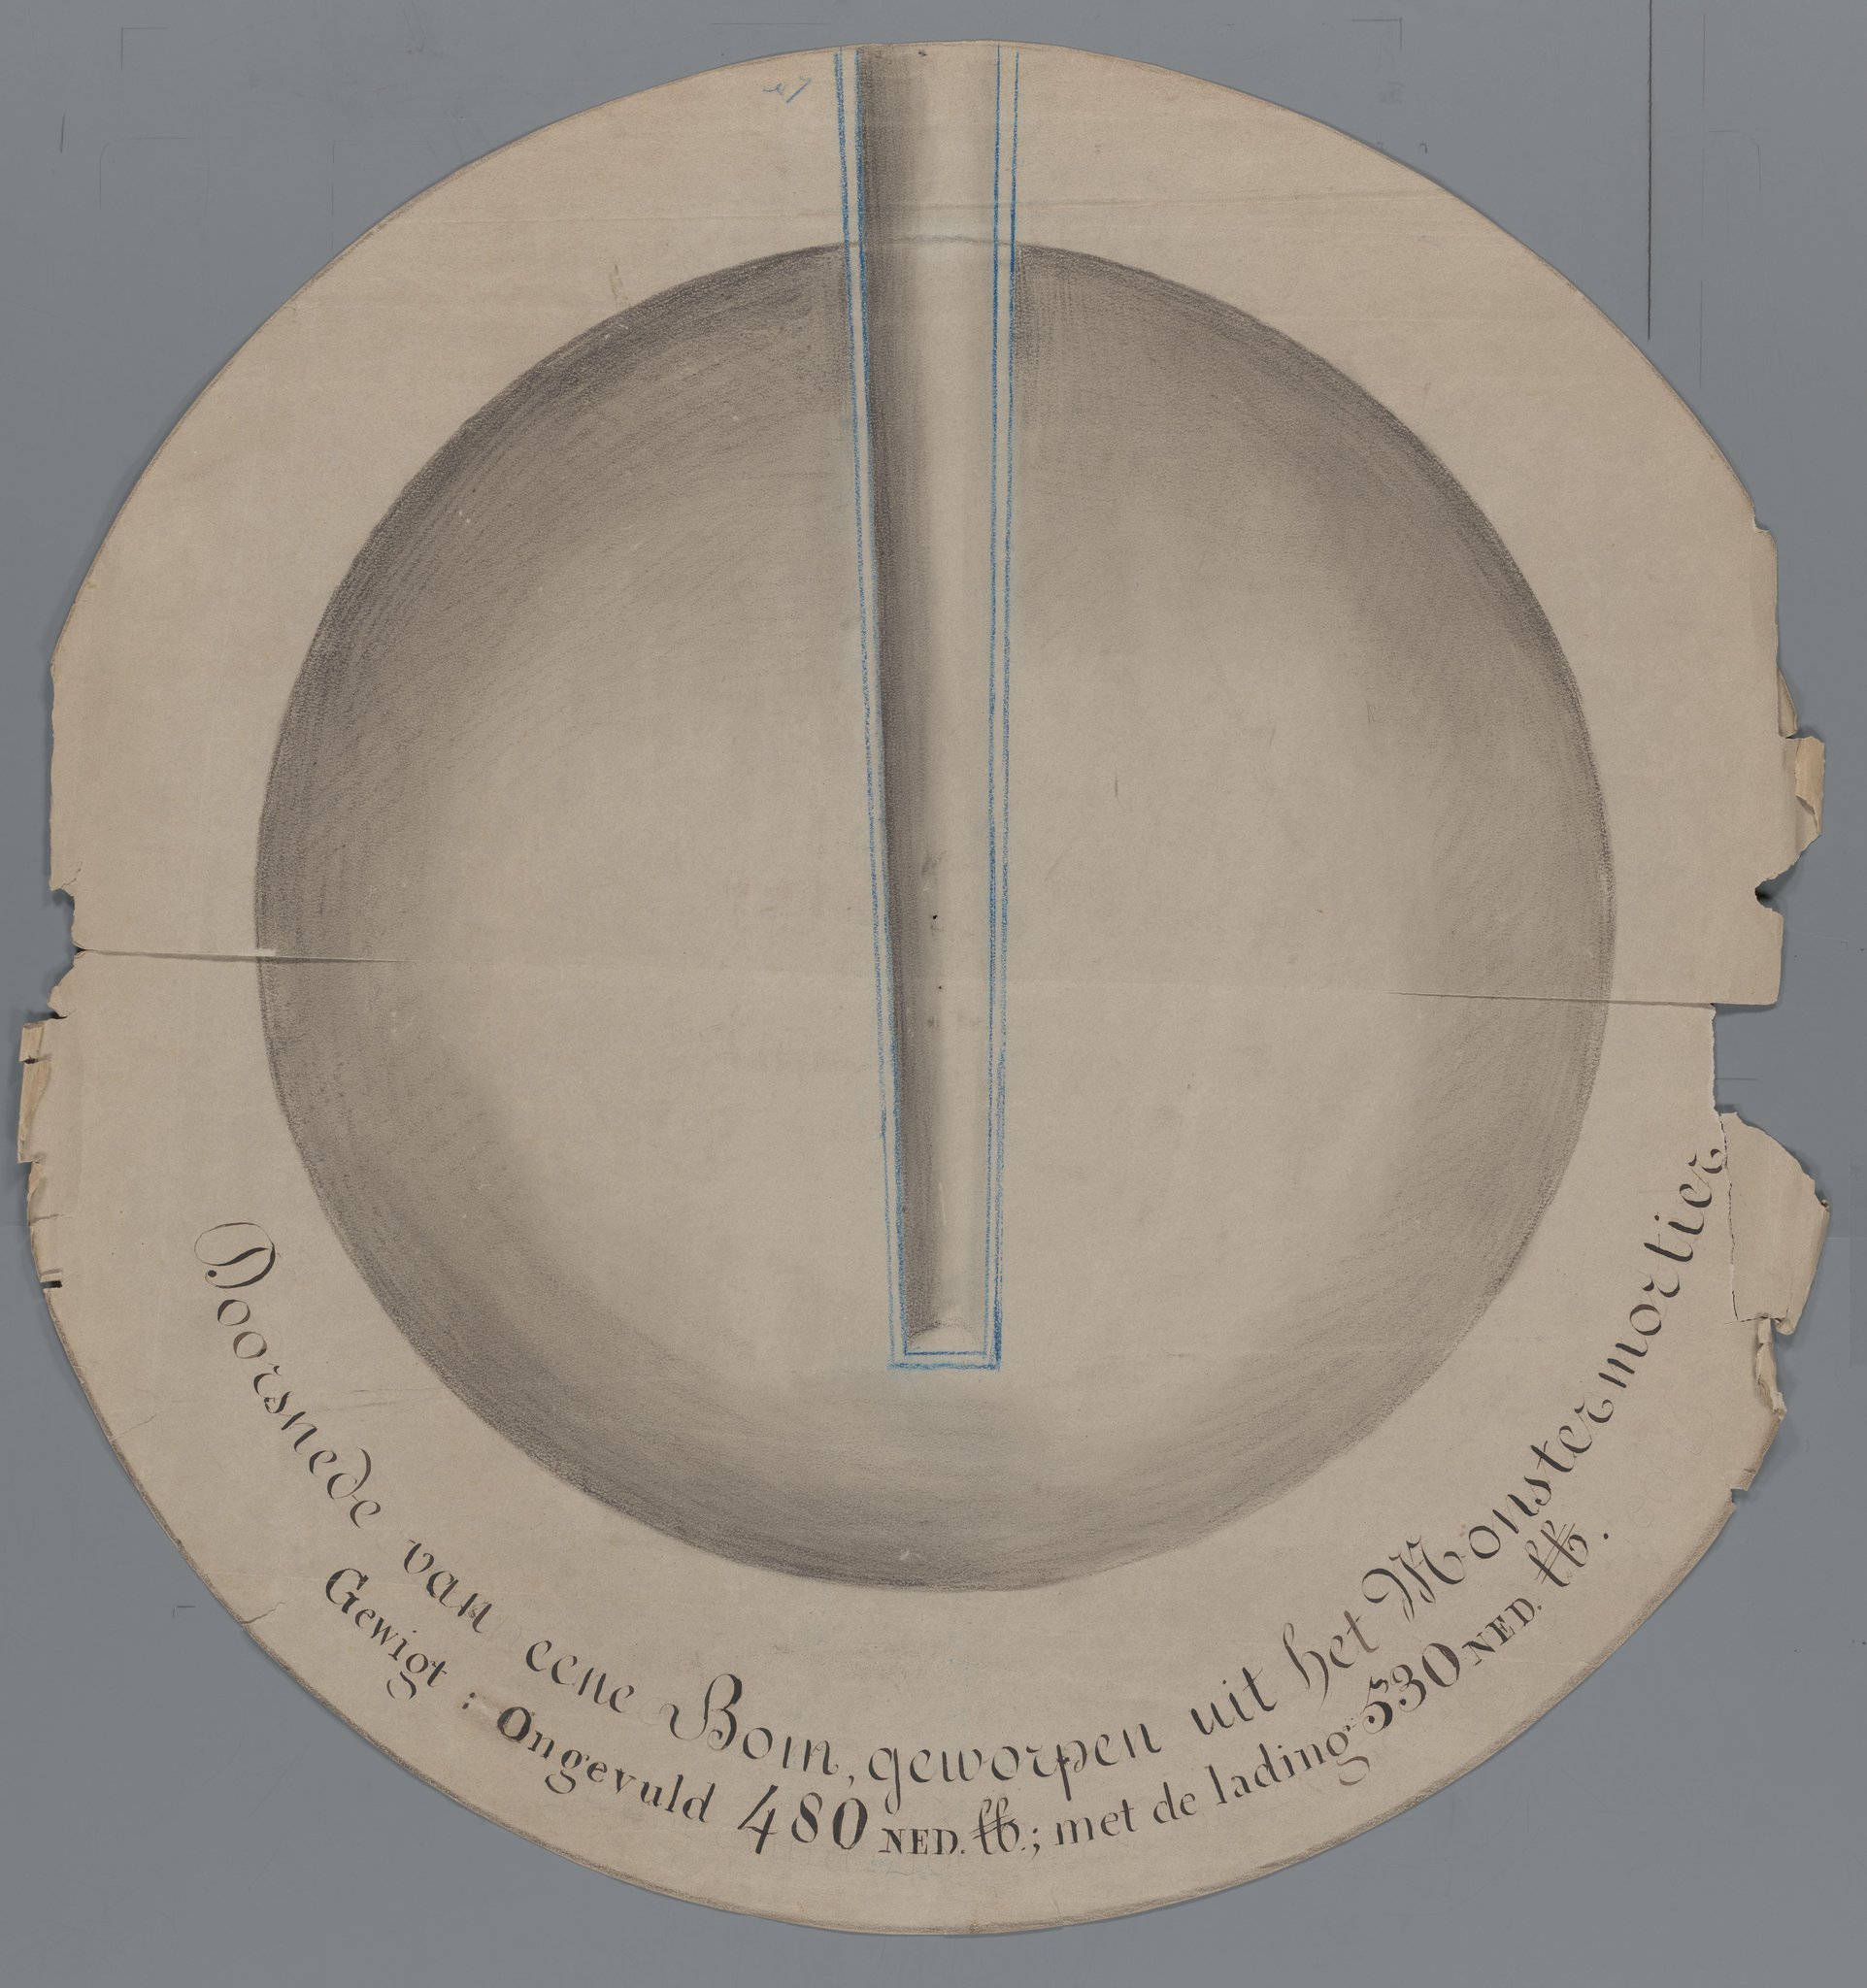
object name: drawing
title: Doorsnede van eene Bom, geworpen uit het Monstermortier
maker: Anonymous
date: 1832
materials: chalk, ink, paper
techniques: drawing, writing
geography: antwerp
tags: projectiles, explosives, etc. (with name), antwerp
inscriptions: inscription: ‘Doorsnede van eene Bom, geworpen uit het Monstermortier / Gewigt Ongevuld 480 Ned. ££; met lading 530 Ned ££ '’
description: Geralateerd aan het beleg van de Citadel van Antwerpen, 1831/1832. Niet in Frederik Muller; door het RPK toegevoegd nummer.